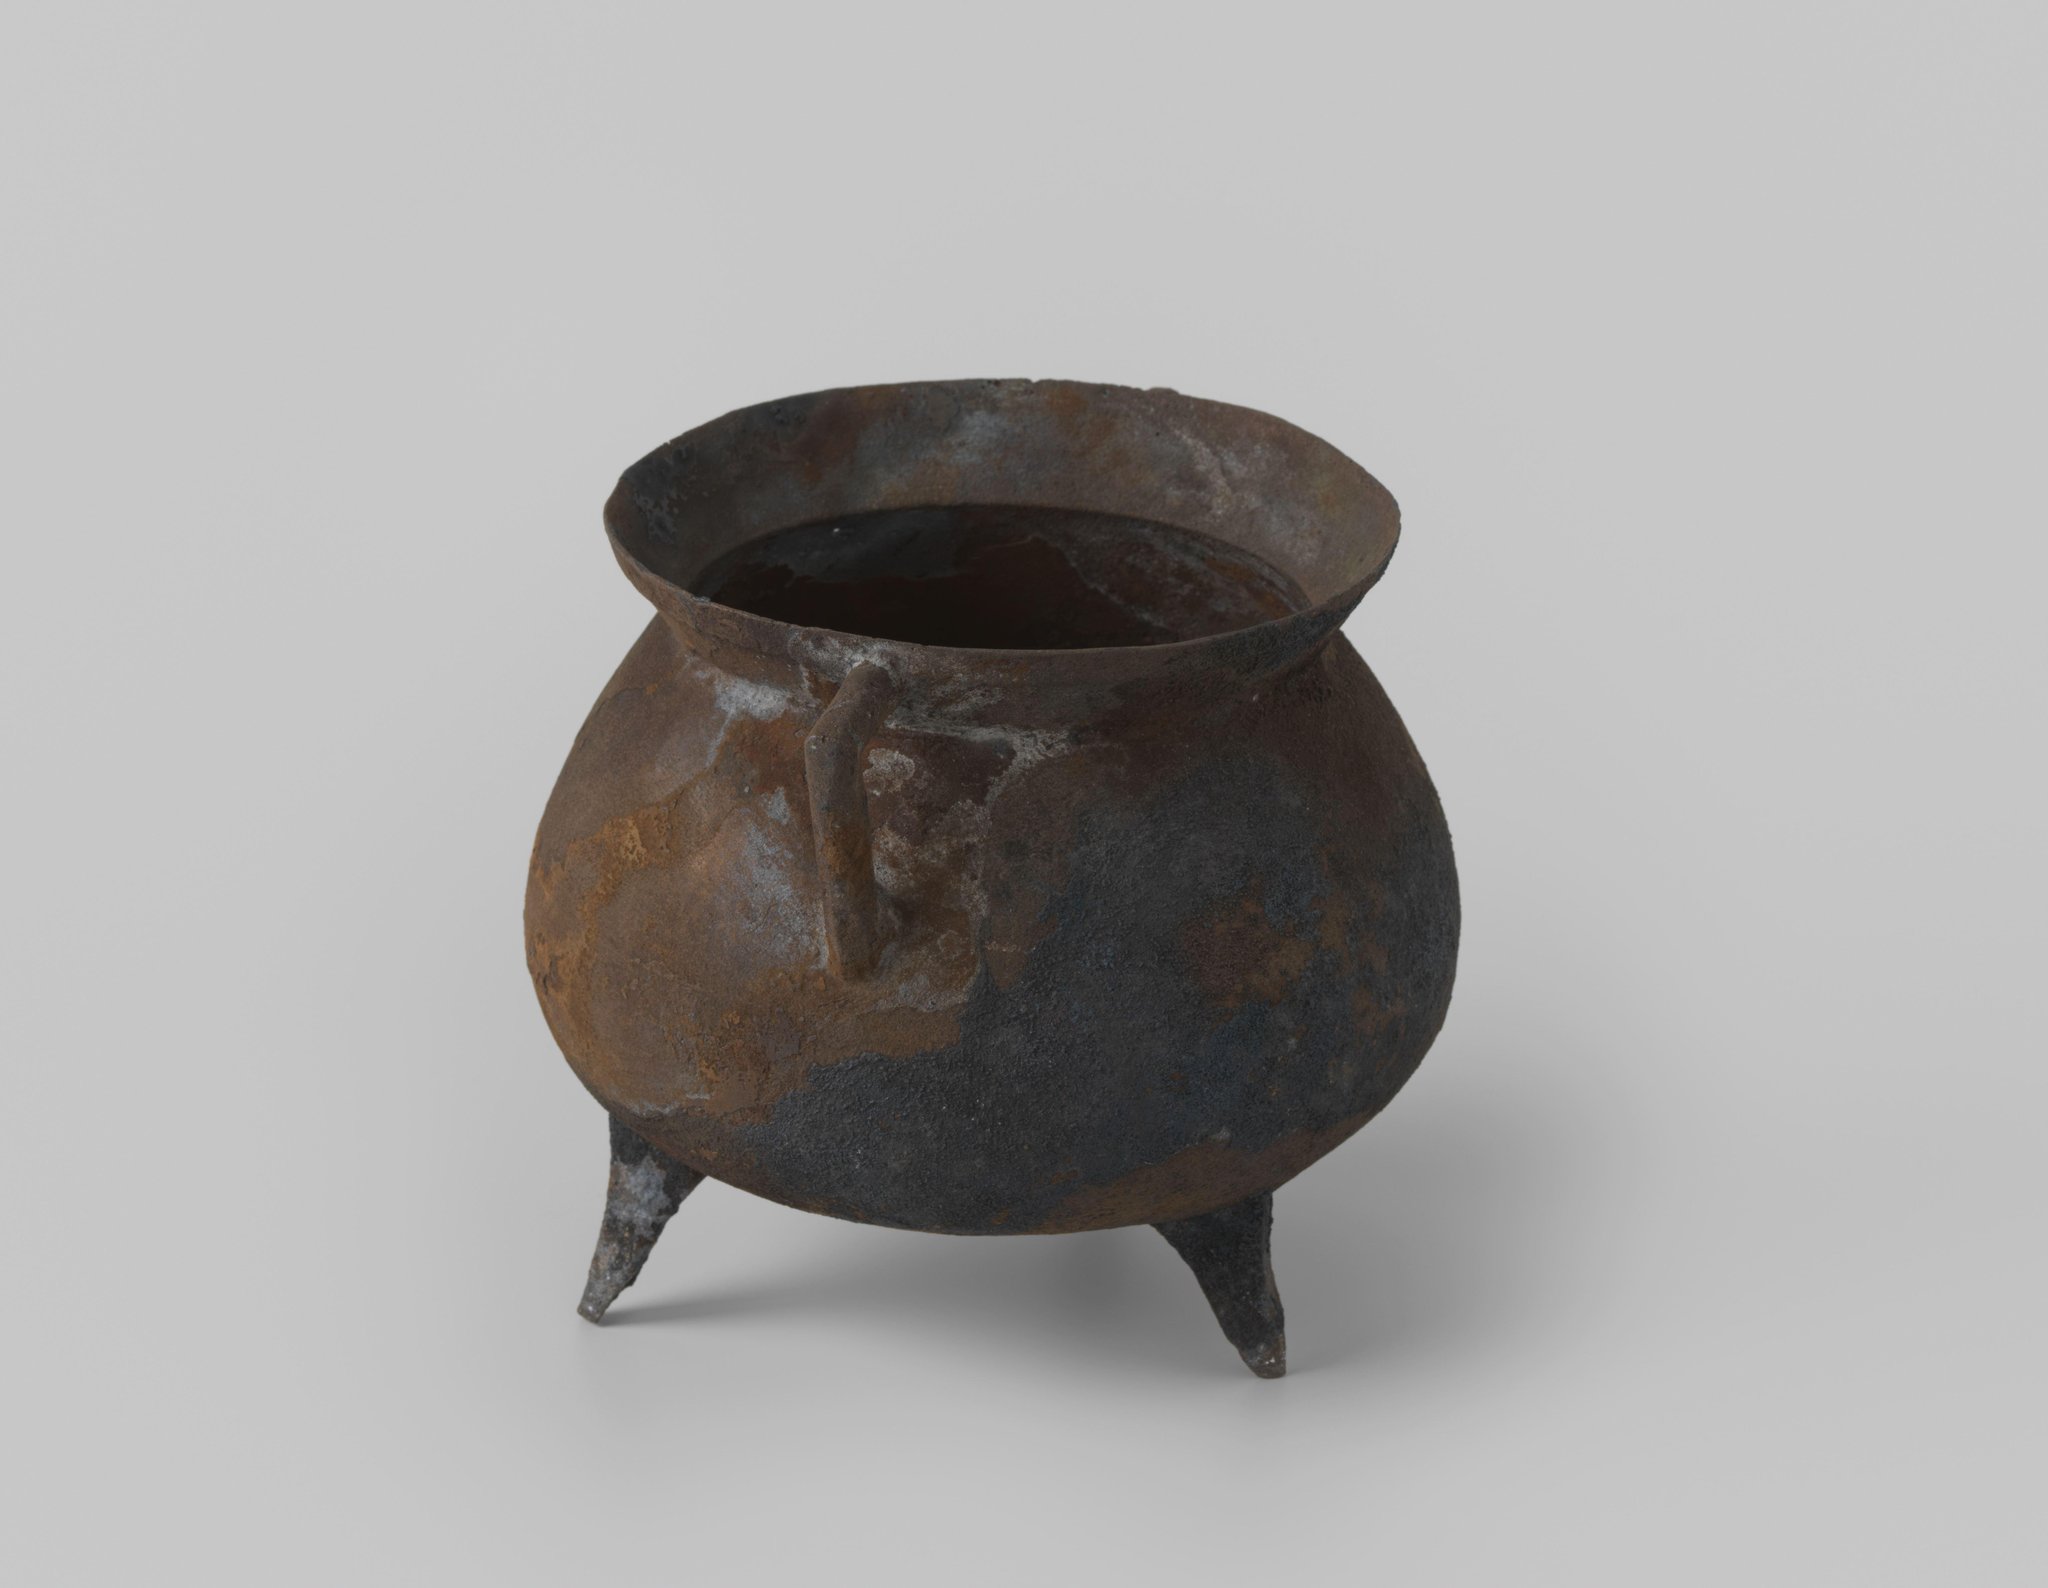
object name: cauldron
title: Kookpot of grape op pootjes uit V.O.C.-schip de 'Witte Leeuw'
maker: Anonymous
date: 1613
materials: bronze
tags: verenigde oostindische compagnie, sint-helena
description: Kookpot op pootjes uit V.O.C.-schip de 'Witte Leeuw'.